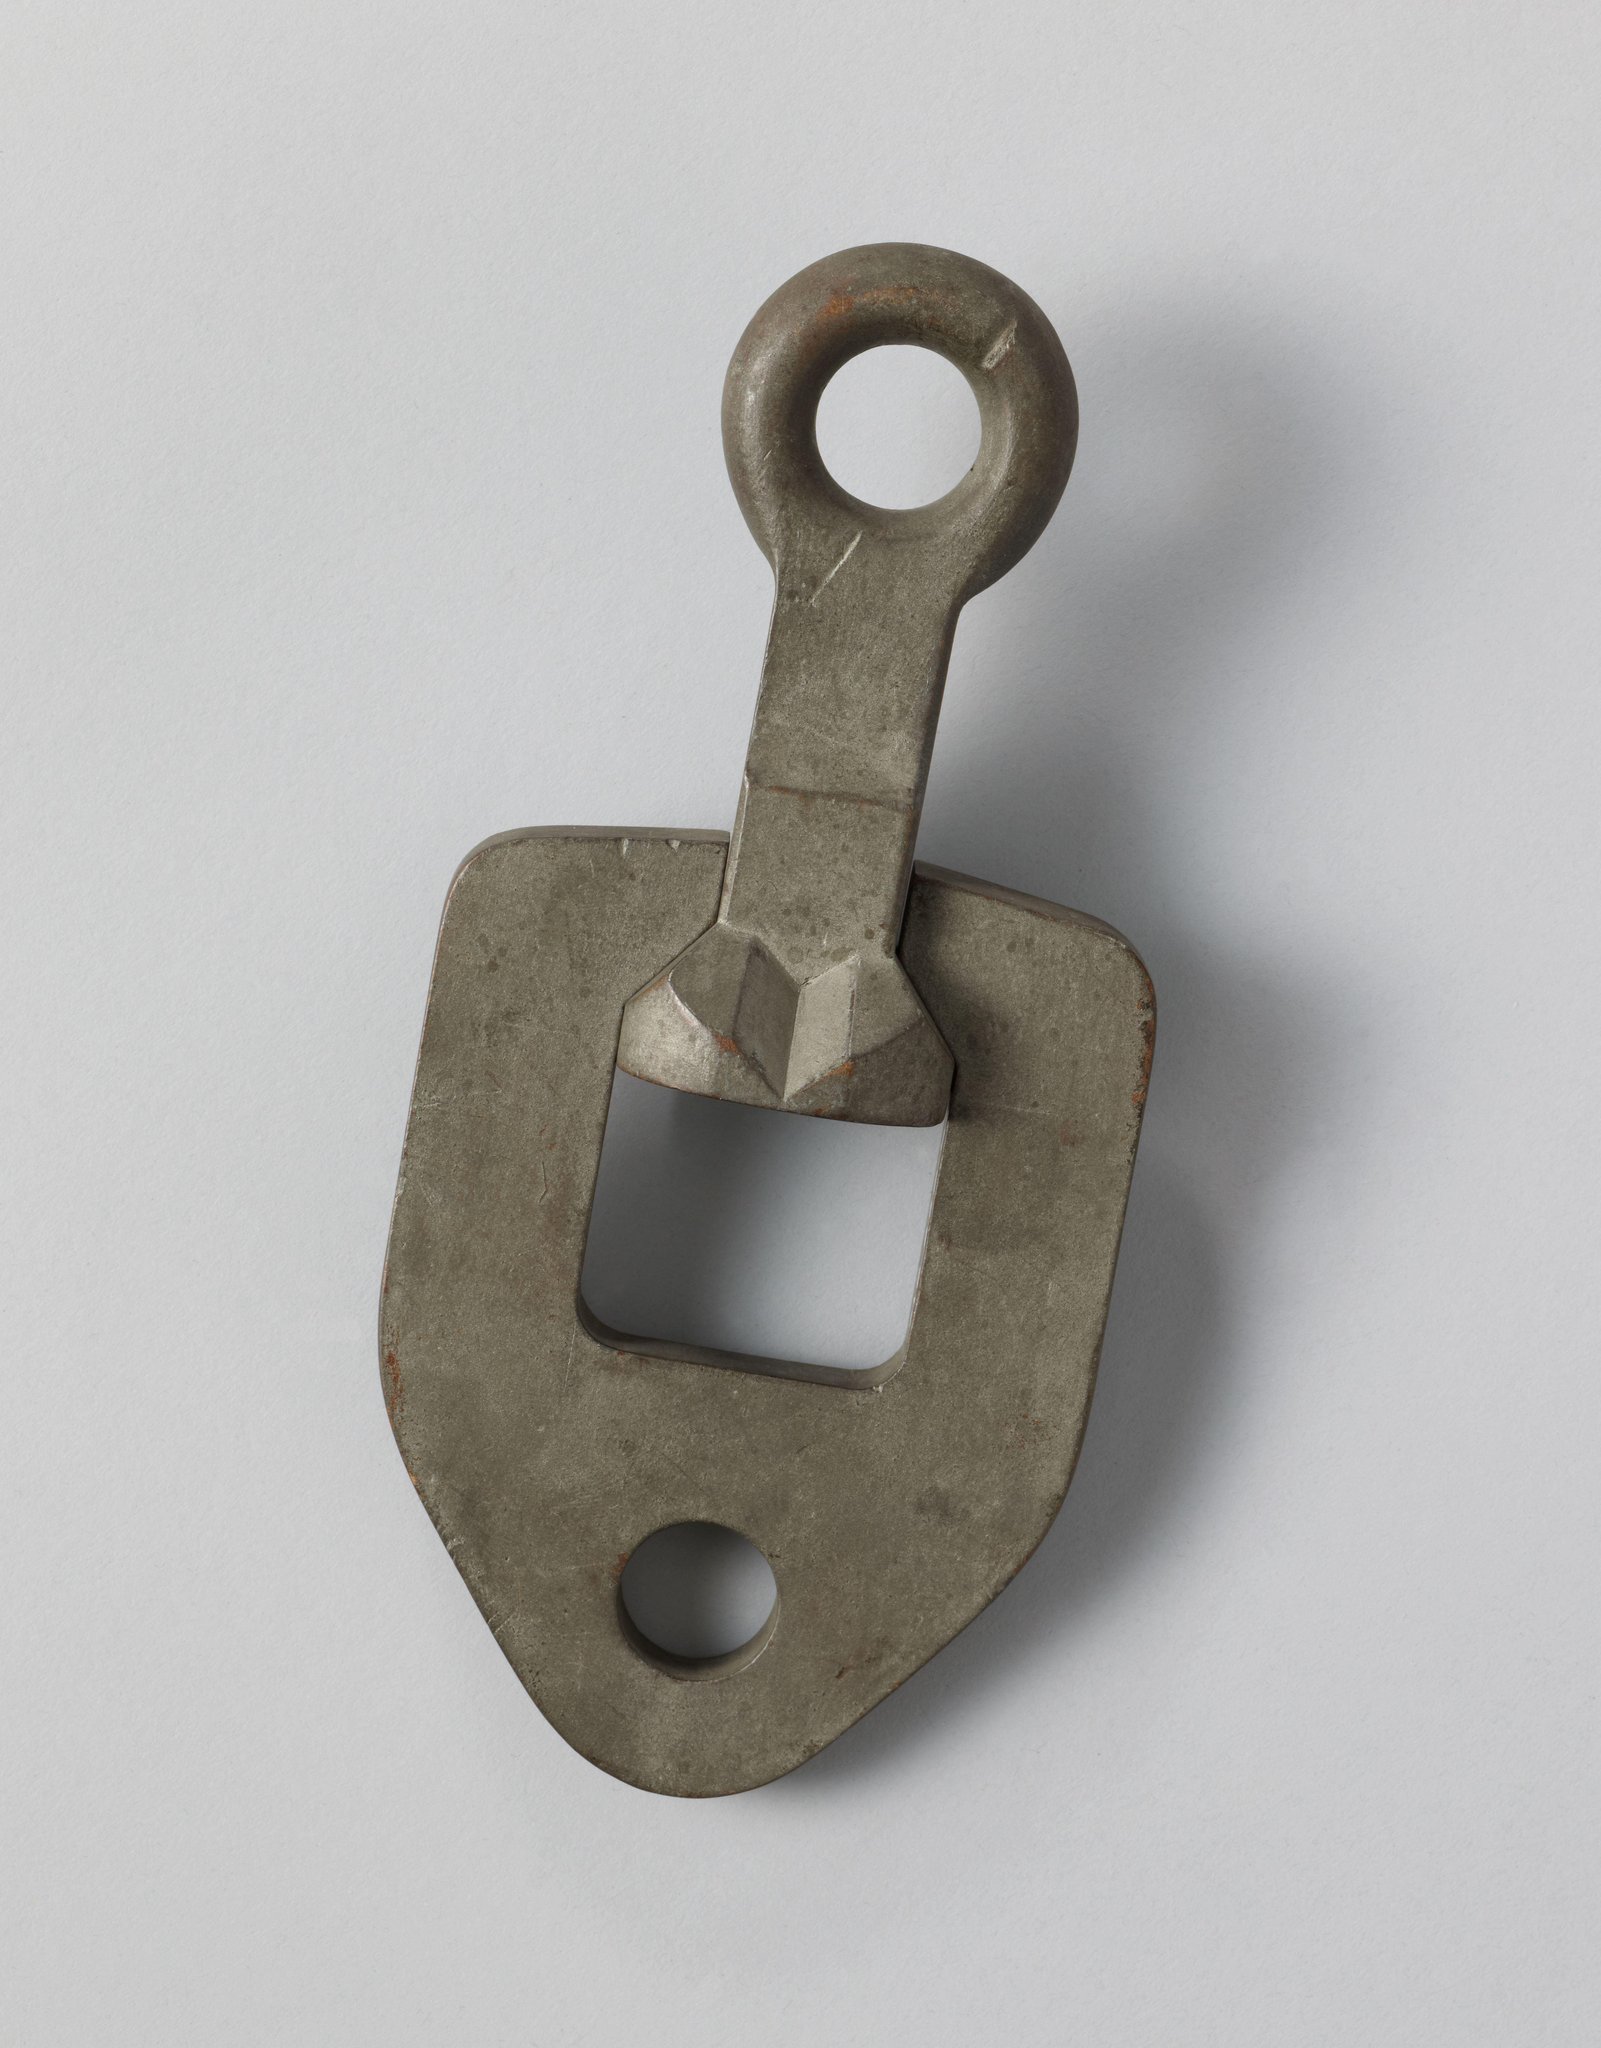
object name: demonstration model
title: Model of a Slip Hook for Lifeboats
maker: petrus van der loo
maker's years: 1806-1864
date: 1857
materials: paint, wood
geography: the hague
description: Houten model van een sliphaak, grijs geverfd, bestaande uit twee delen: een kram, die met een oog in de vloer van de boot wordt vastgezet, en een sleutel met een oog voor het takel van de davit en een dik uiteinde met V-vormige groeven. Dit kan niet door de opening van de kram, die door dikker wordende benen verkleind wordt en de sleutel vastklemt. Pas als de boot in het water ligt en de spanning van het takel weg is, valt de sleutel door eigen gewicht en komt het takel vrij. De groeven weerhouden de sleutel ervan uit de kram te glijden.